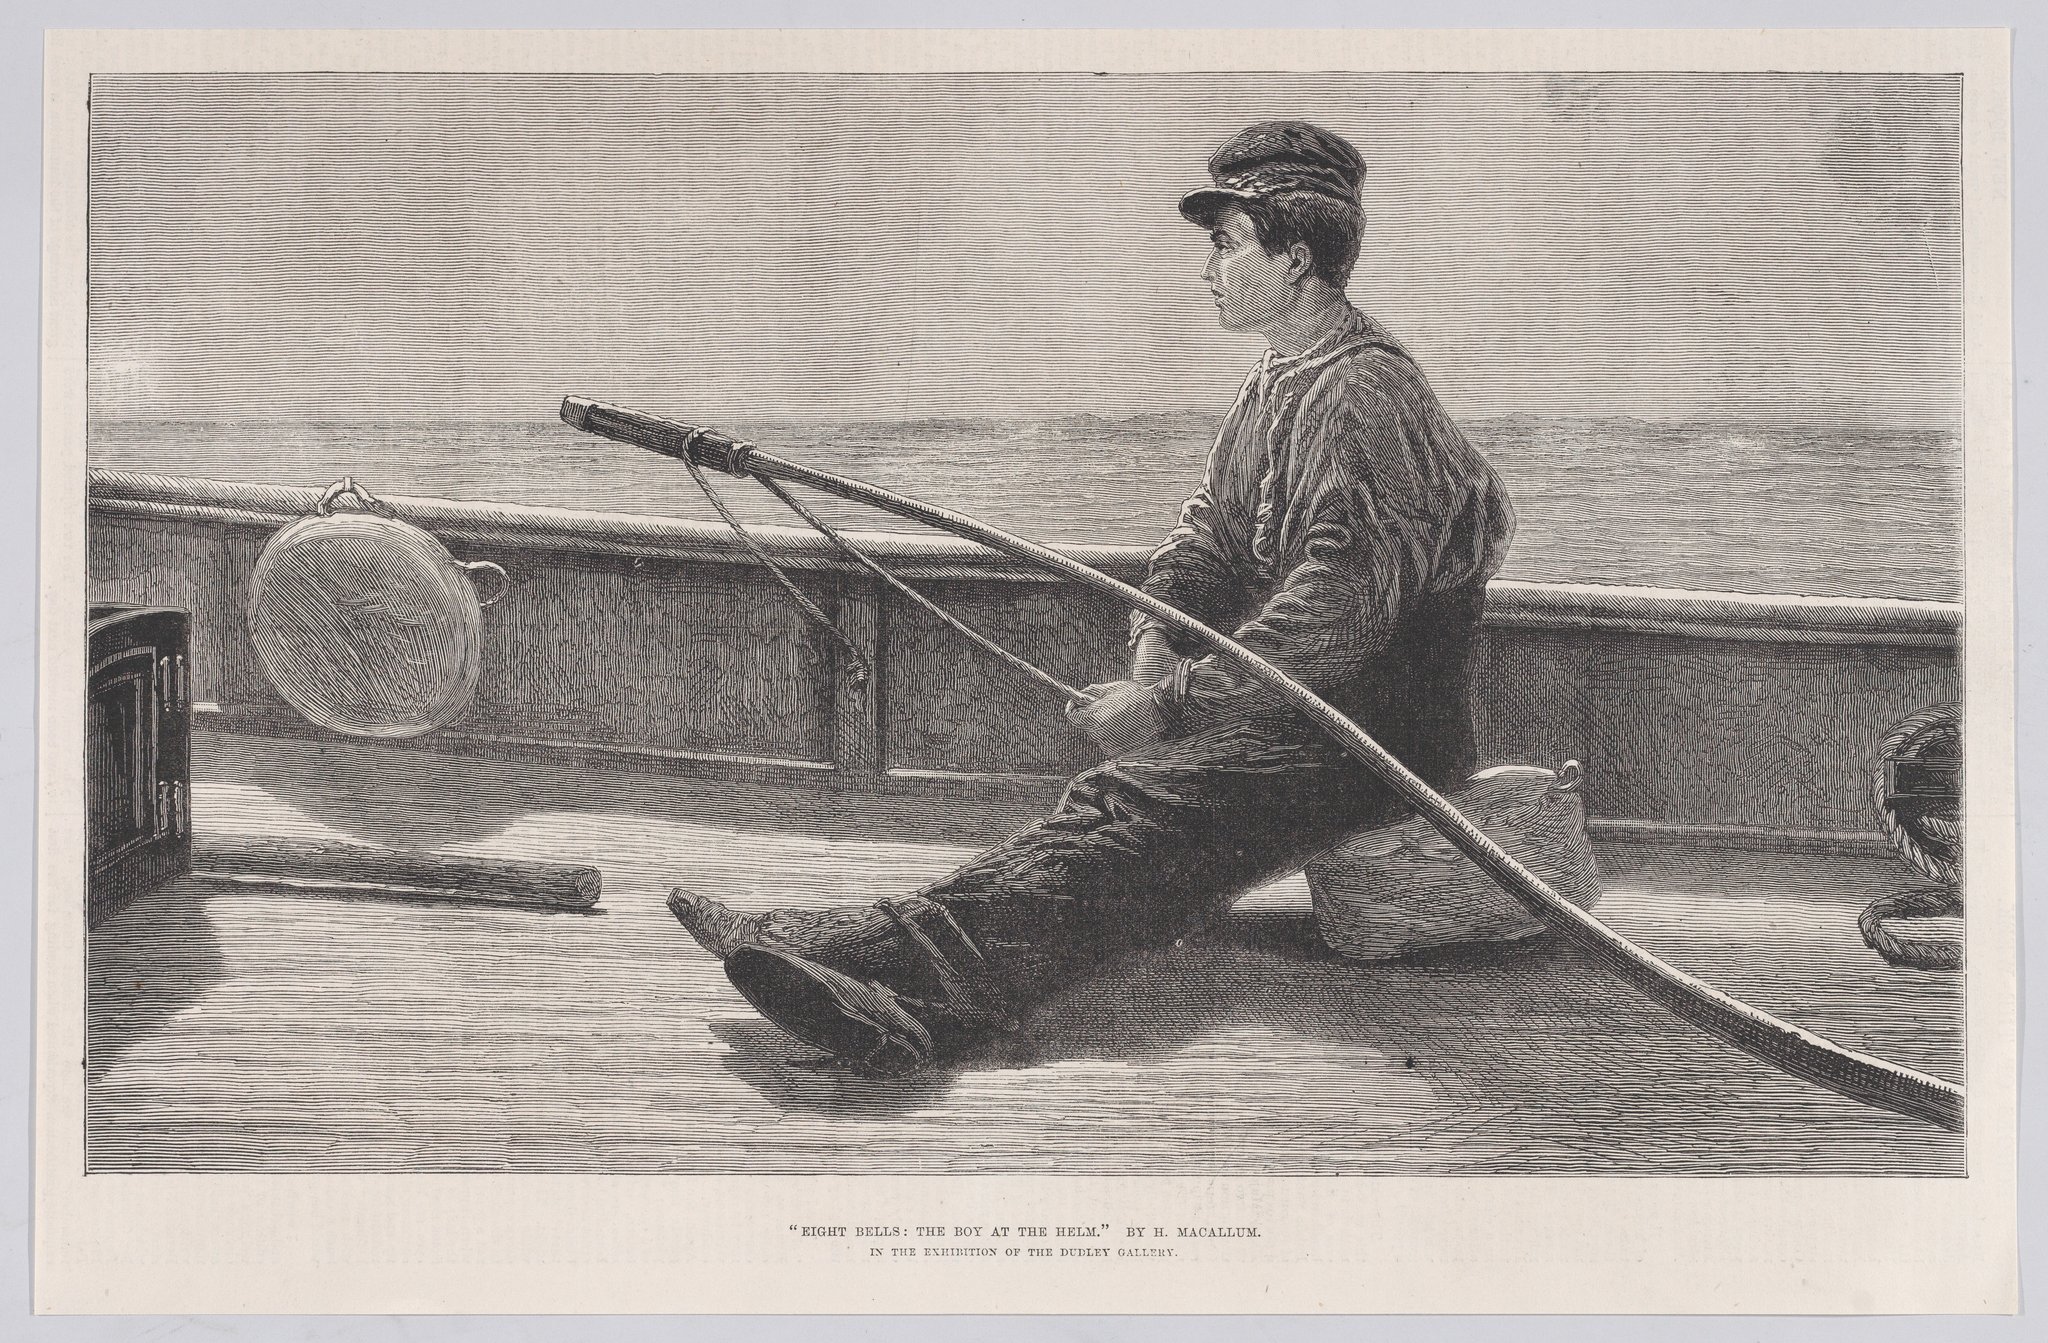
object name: print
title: Eight Bells: The Boy at the Helm, from "Illustrated London News"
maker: hamilton macallum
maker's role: artist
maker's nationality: british, scottish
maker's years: 1841-1896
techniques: engraving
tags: boys,boats